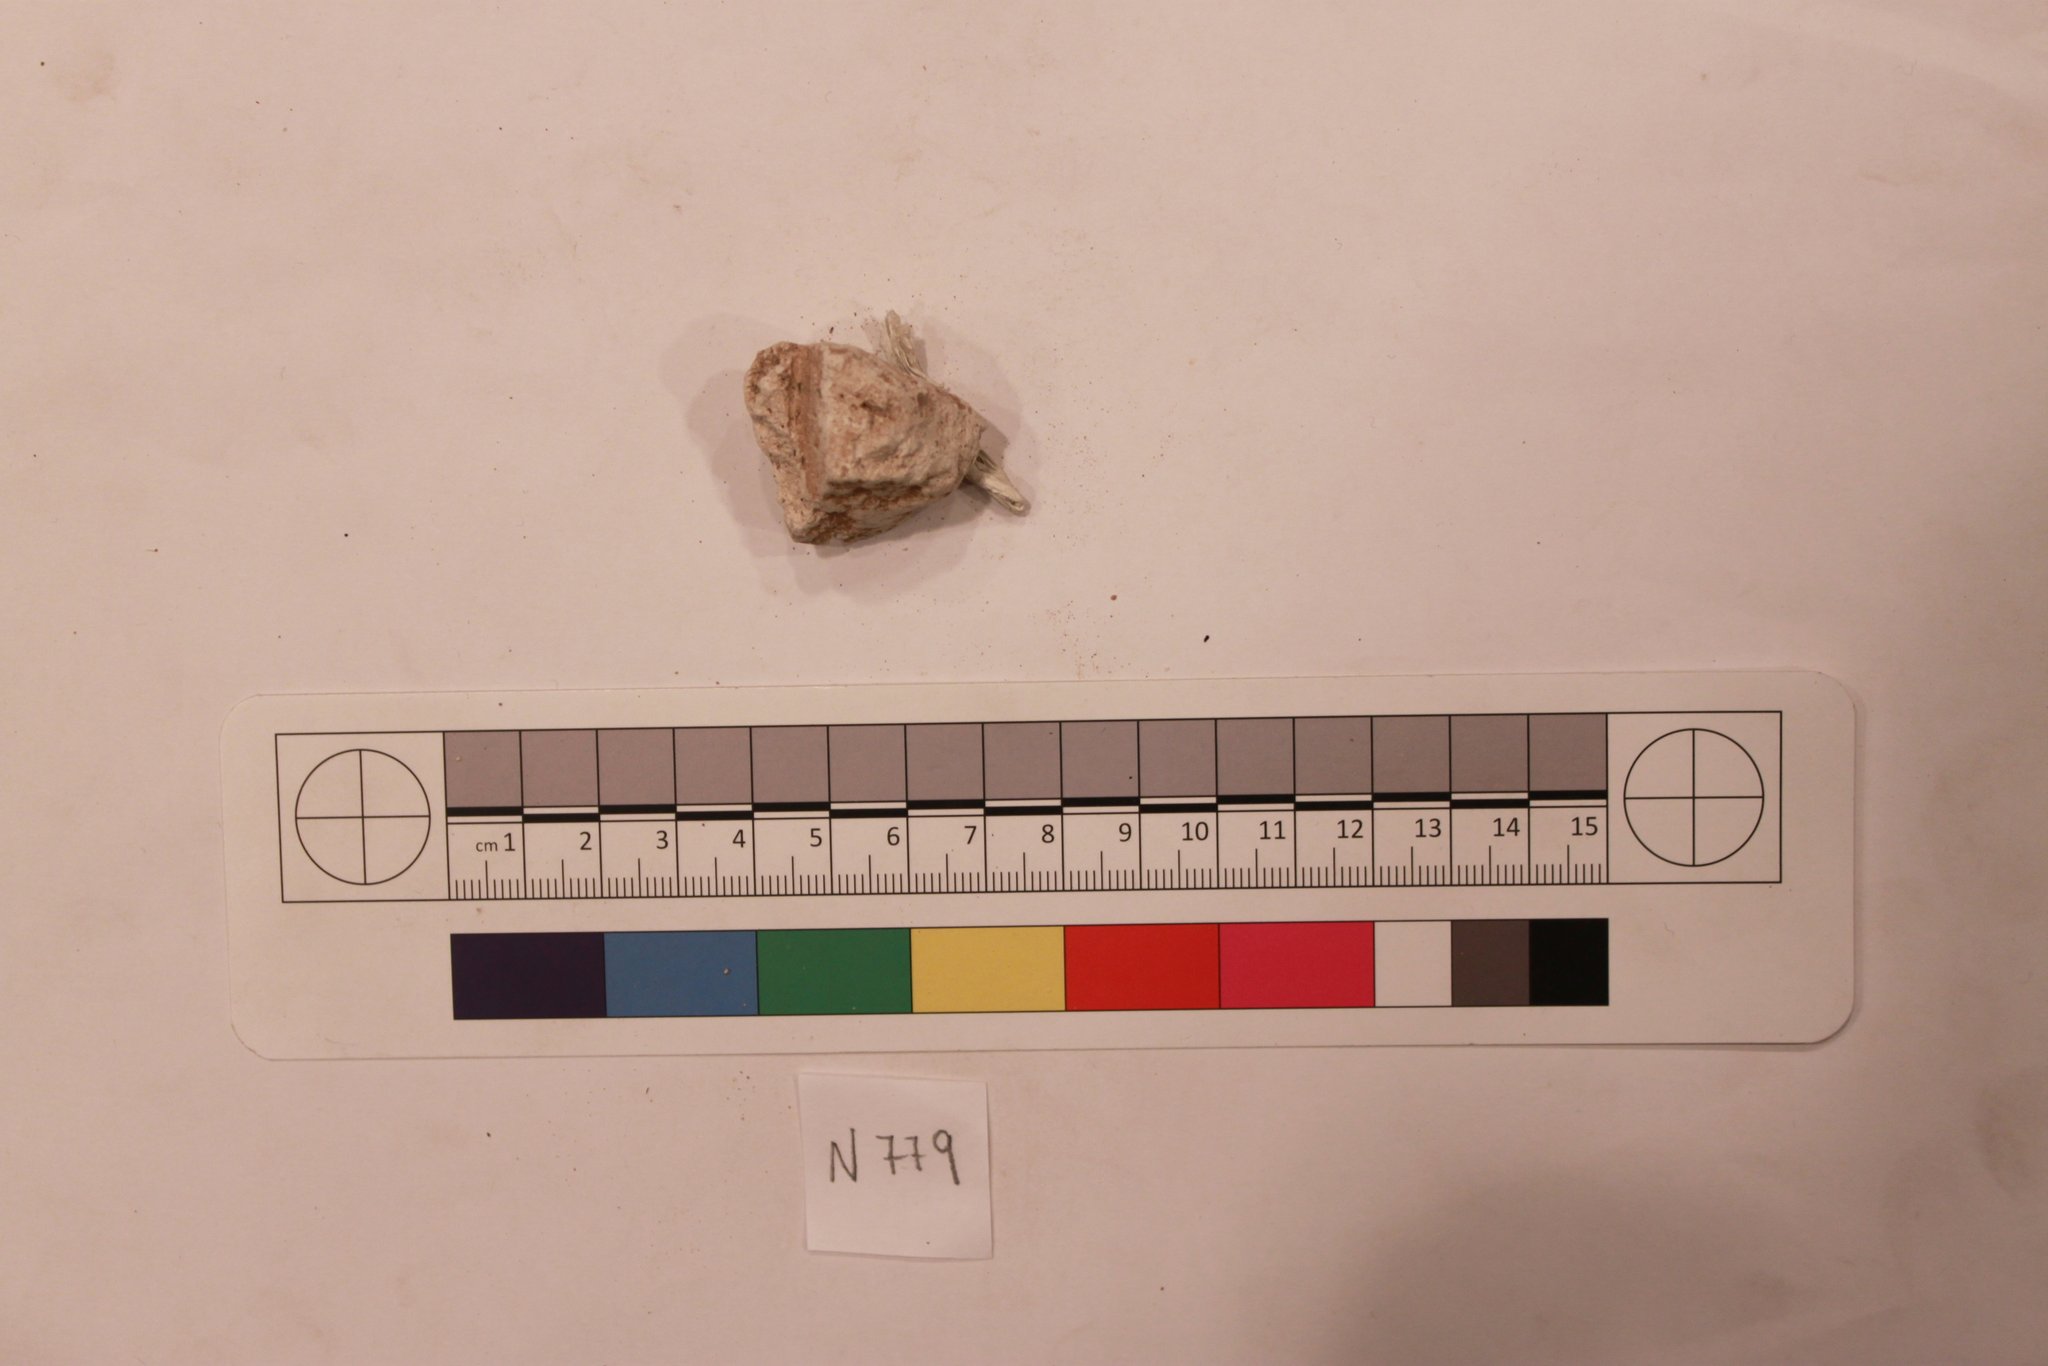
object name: fragment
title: Stucco Fragment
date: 701-1200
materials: plaster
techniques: carving, painting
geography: iran